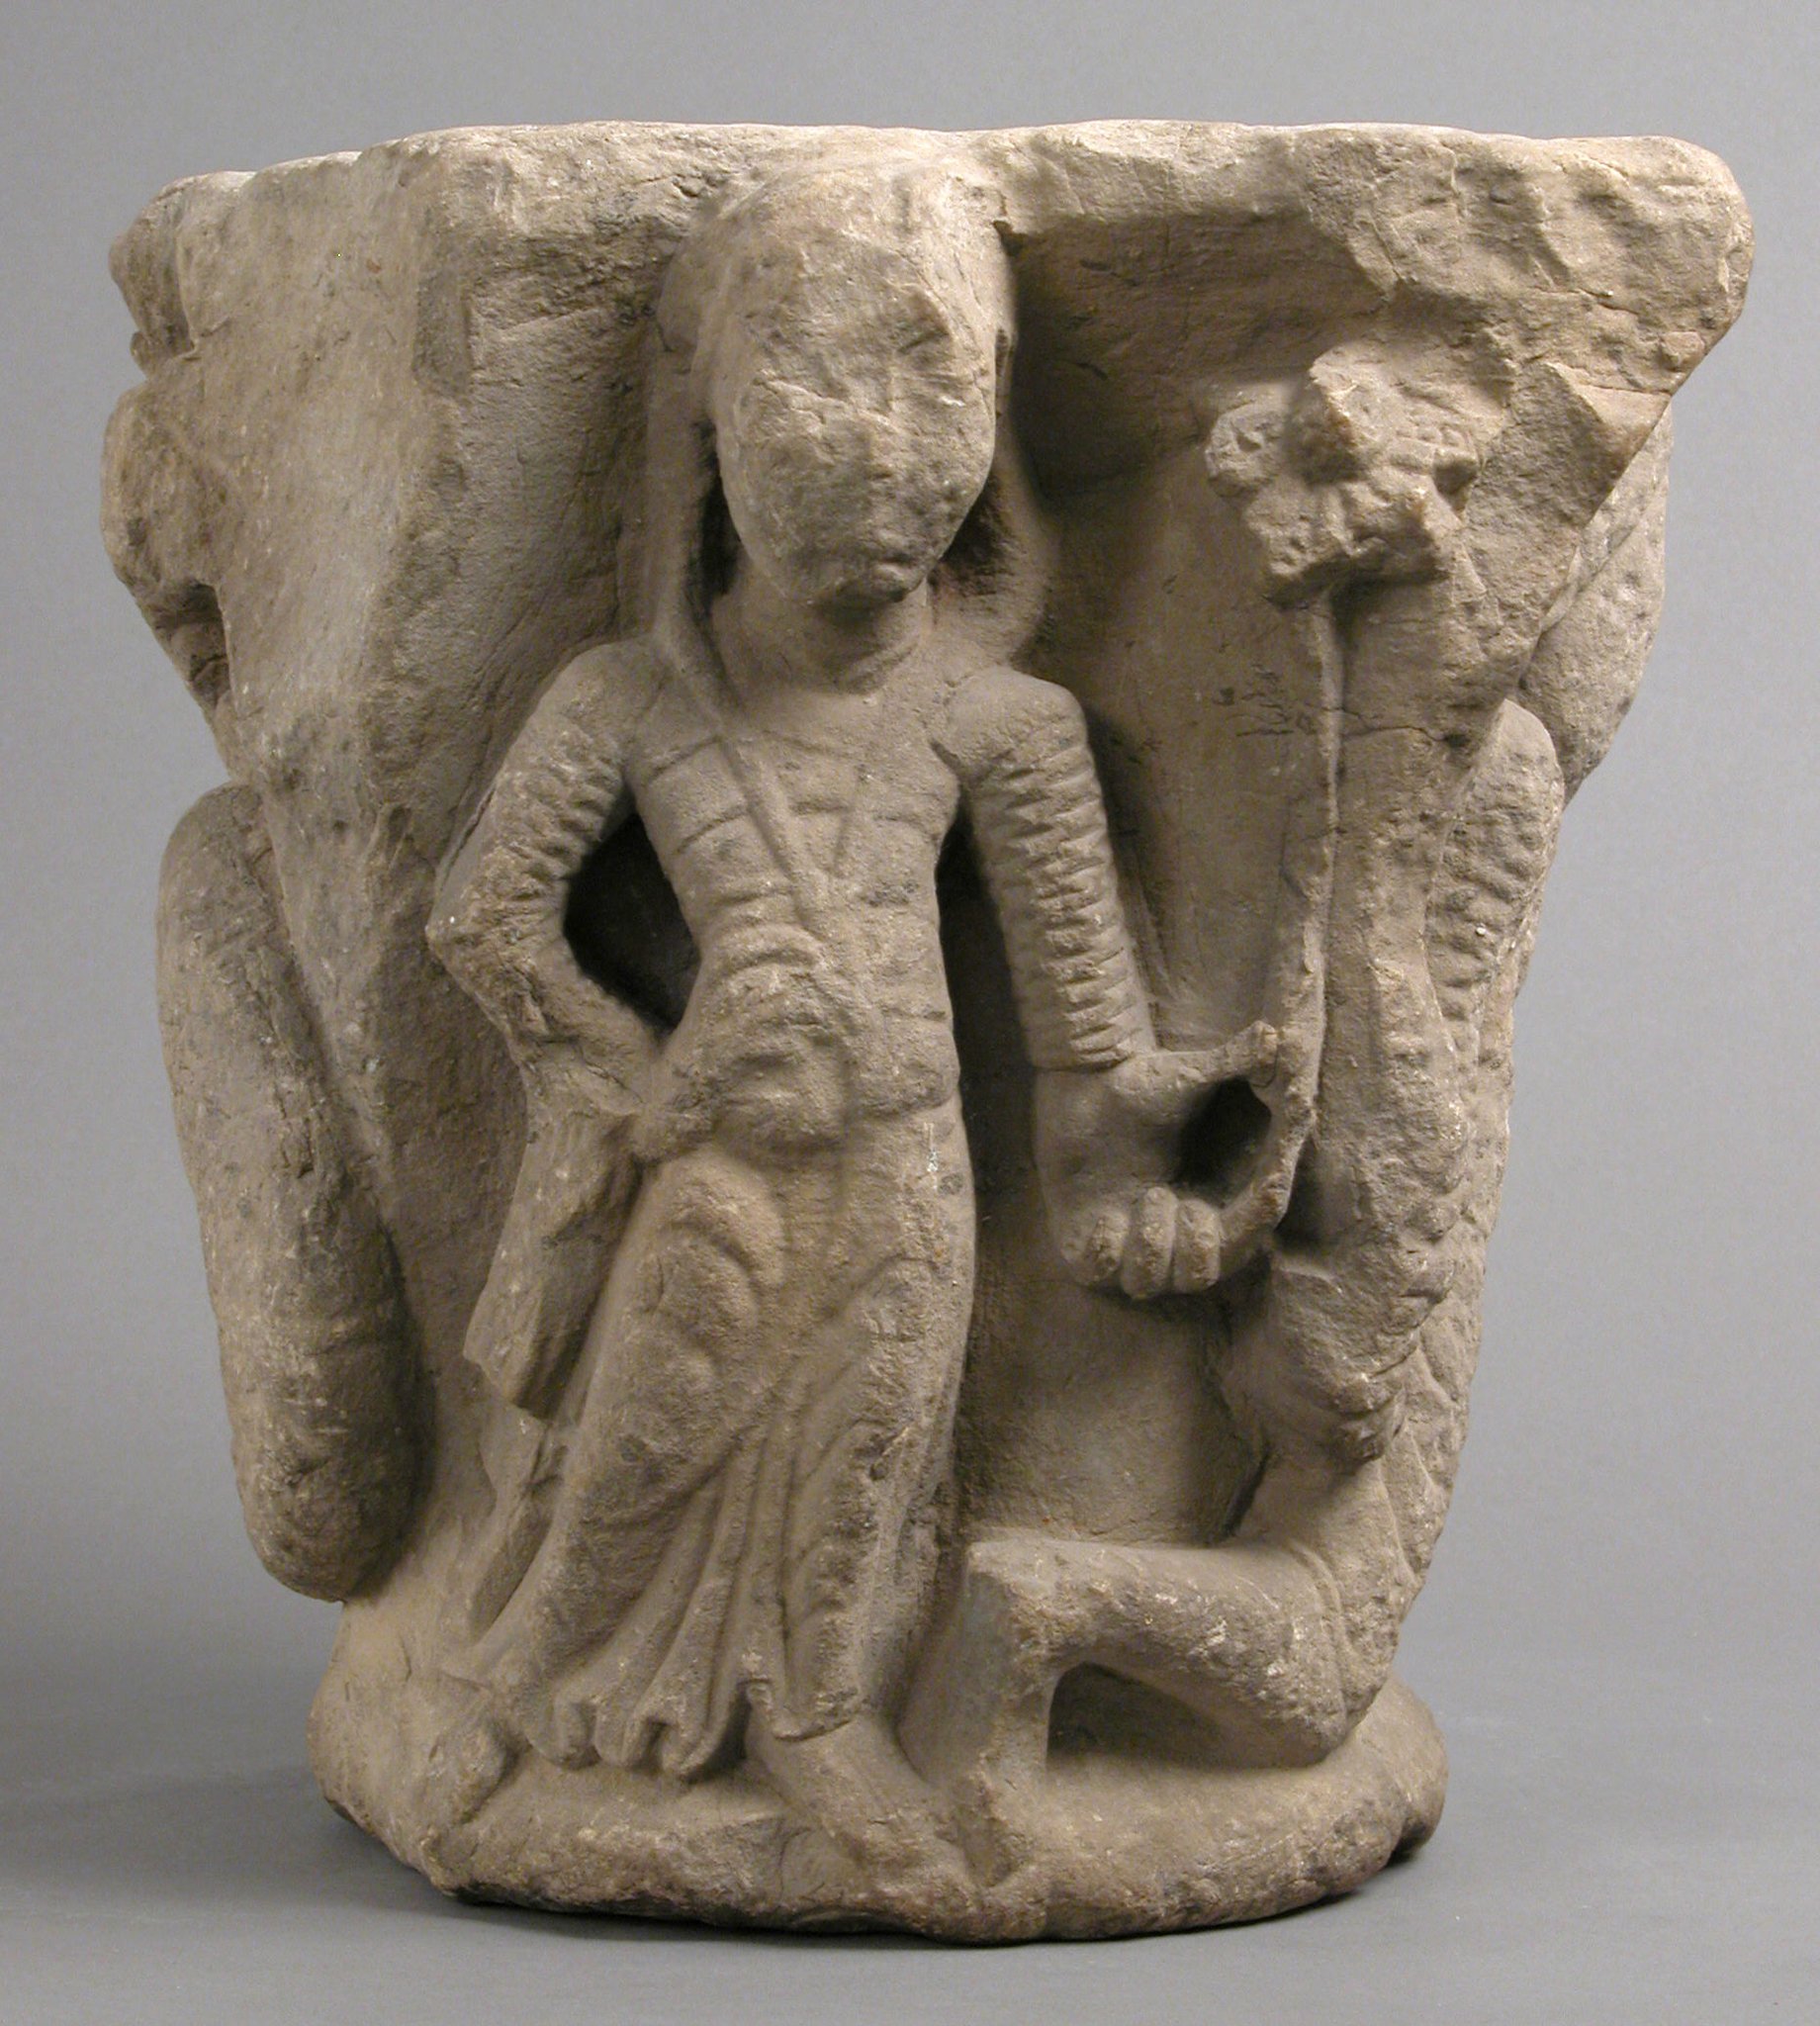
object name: capital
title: Capital with Saint George and the Dragon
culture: french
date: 1101-1300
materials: stone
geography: france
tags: dragons,saint george